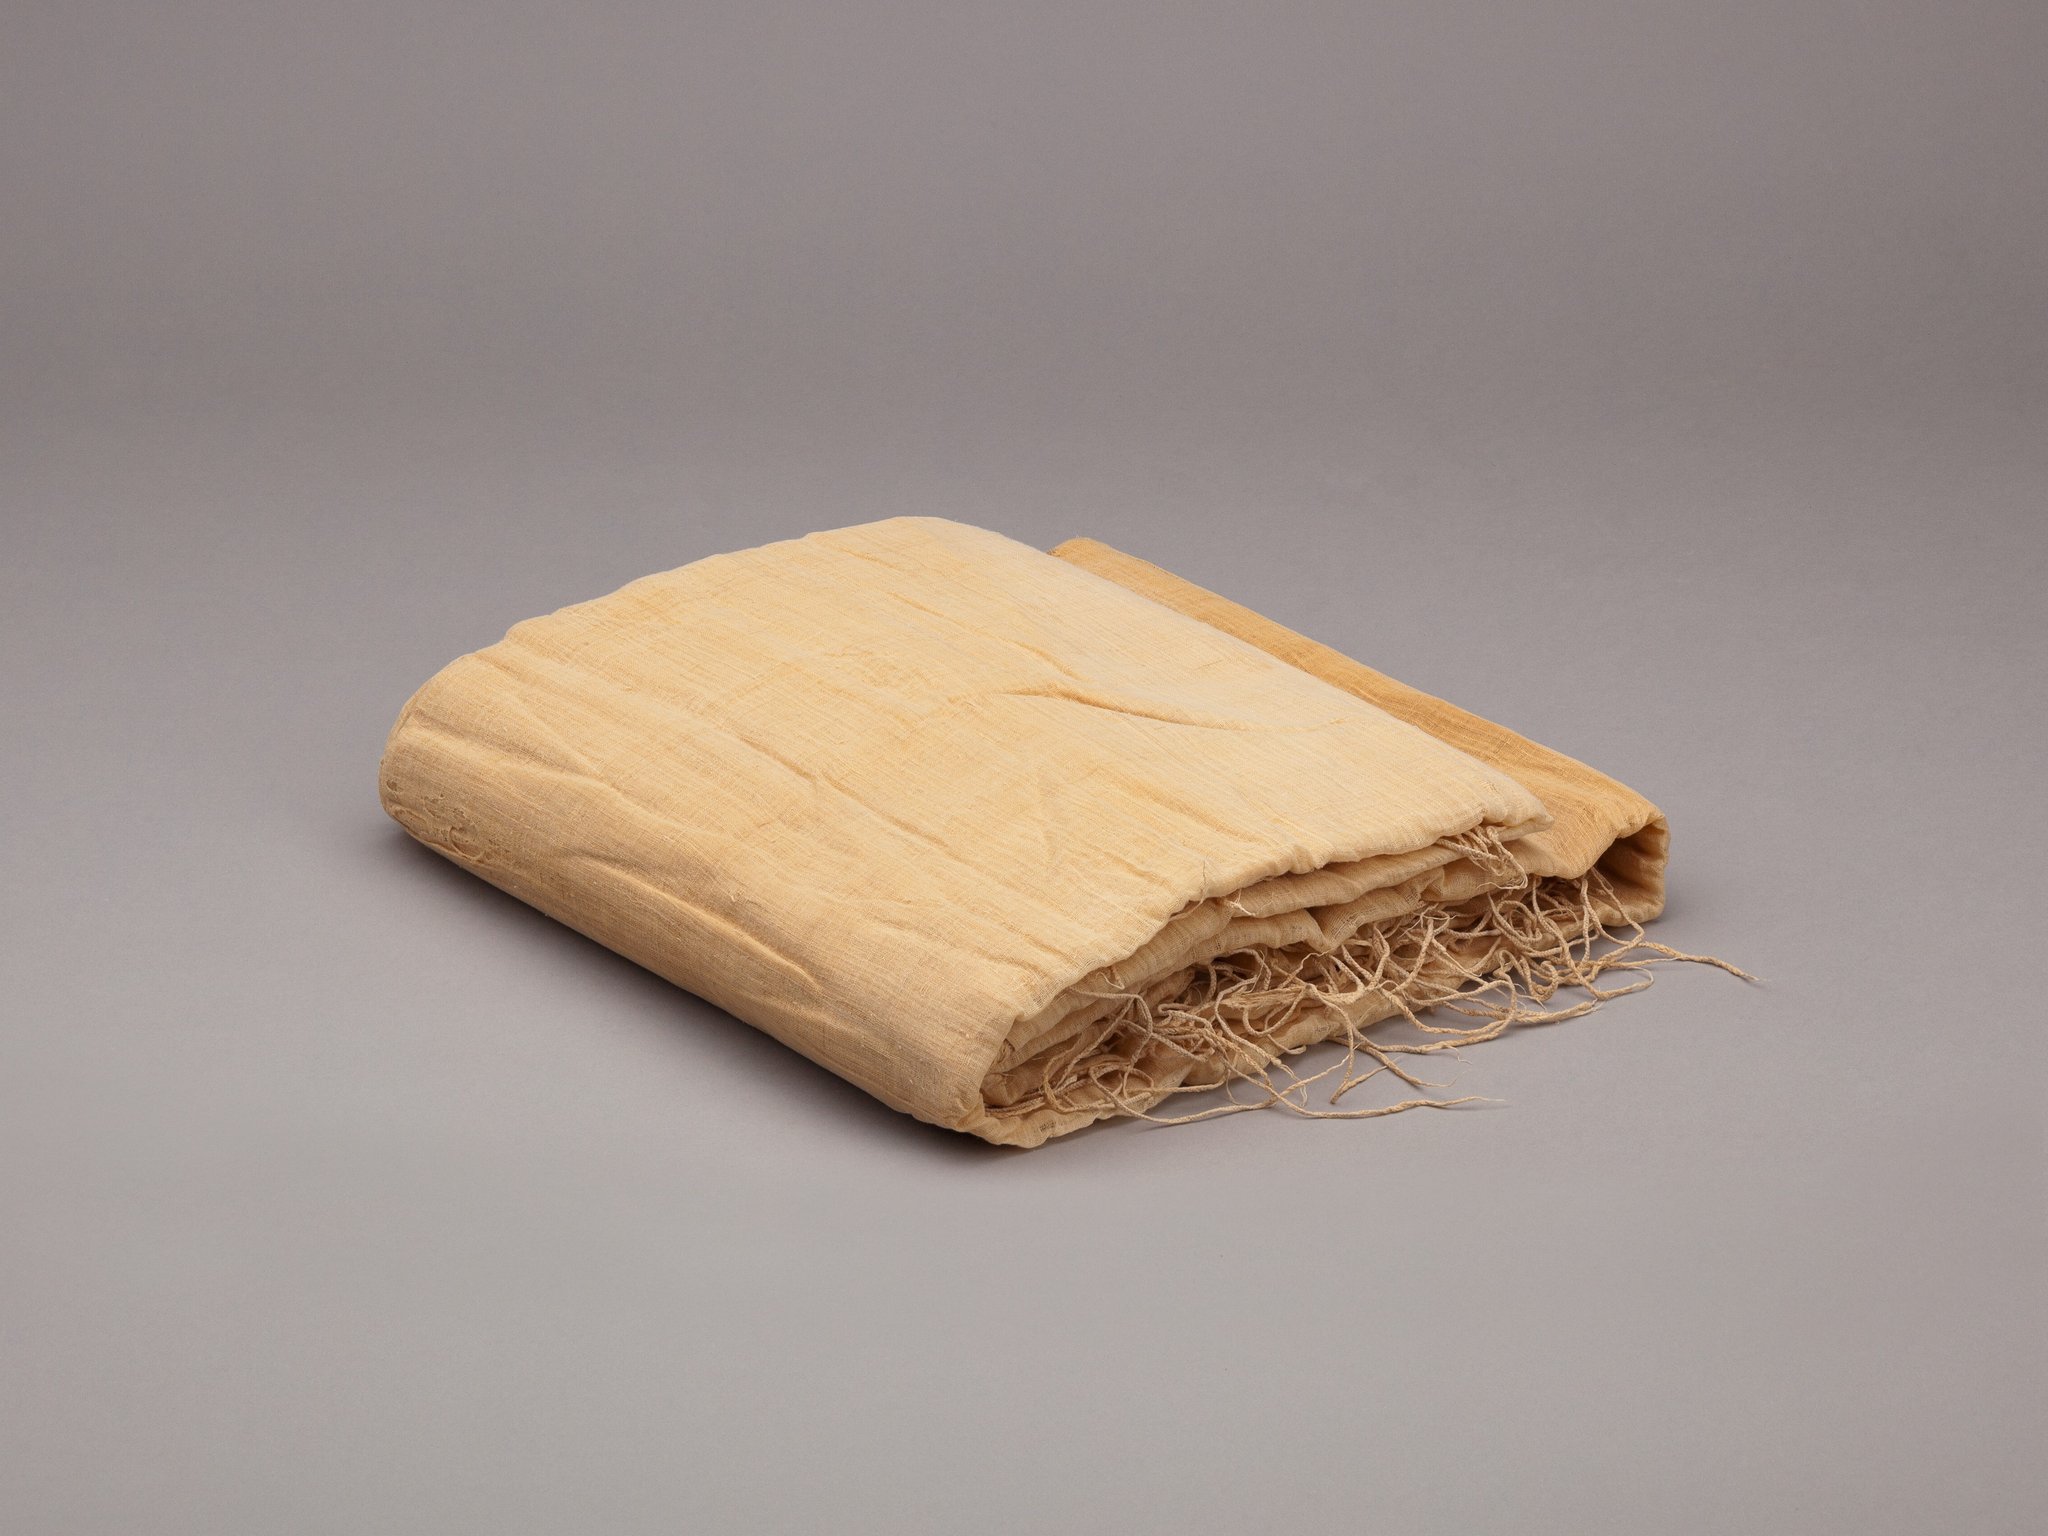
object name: linen mark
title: Sheet, linen mark, fine spin, medium weave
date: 1492-1473 BCE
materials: linen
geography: egypt